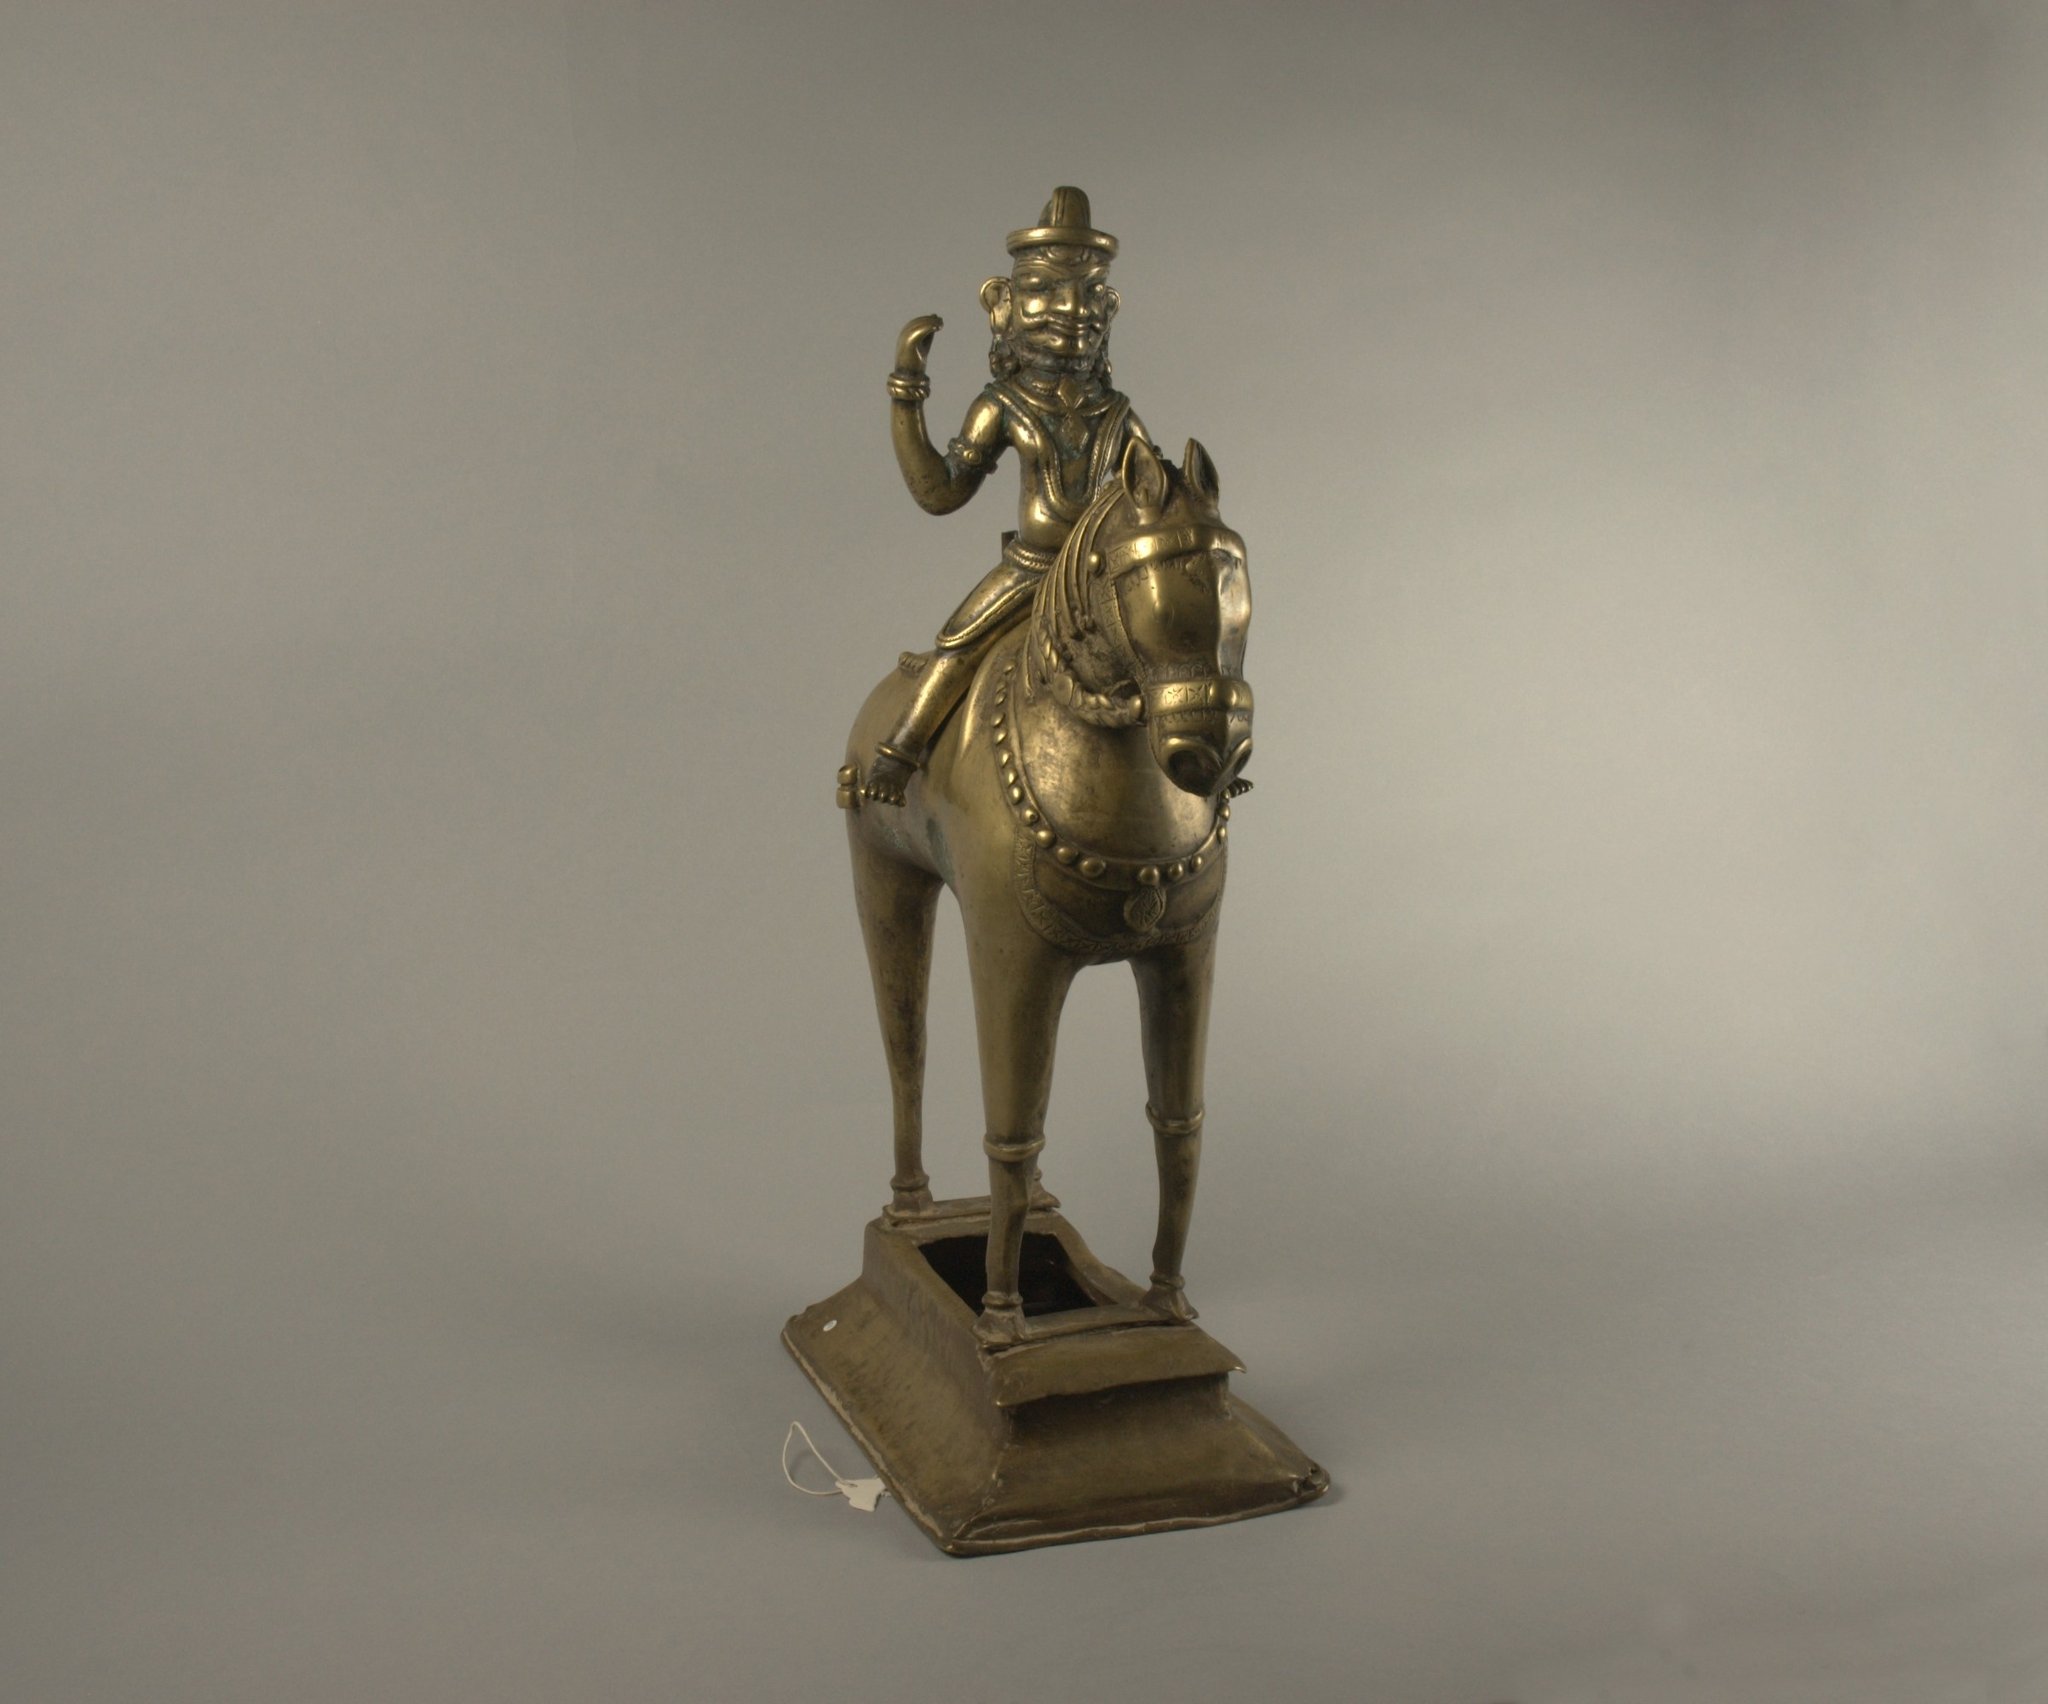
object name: figure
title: Khandoba on a Horse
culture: indian, maharashtra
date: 1701-1800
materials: brass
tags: horses,hinduism